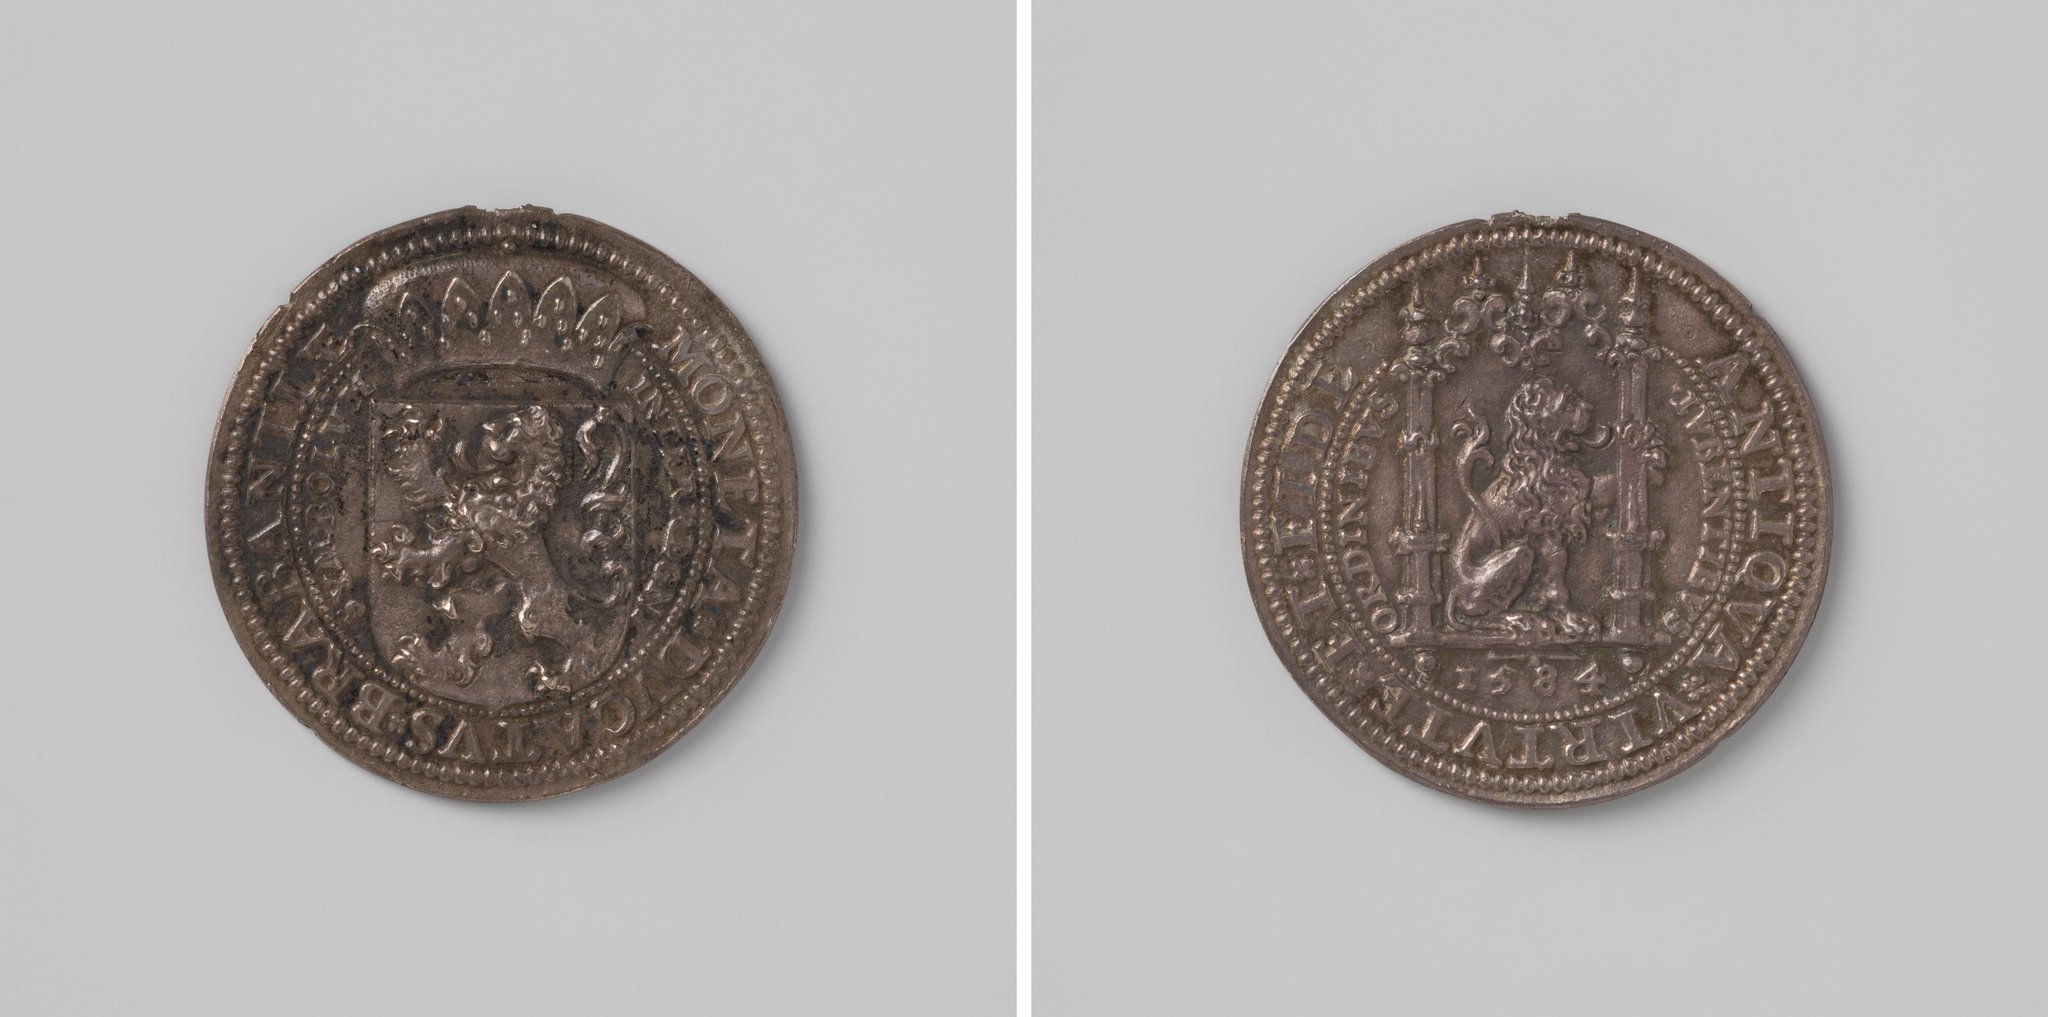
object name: medal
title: Vrije hertogdom Brabant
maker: jacques jonghelinck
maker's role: medailleur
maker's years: 1530-1606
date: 1584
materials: silver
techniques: casting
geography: brabant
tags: brabant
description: Zilveren penning. Voorzijde: gekroond wapenschild binnen tweeregelig omschrift. Keerzijde: leeuw, zittend binnen erepoort boven jaartal binnen omschrift